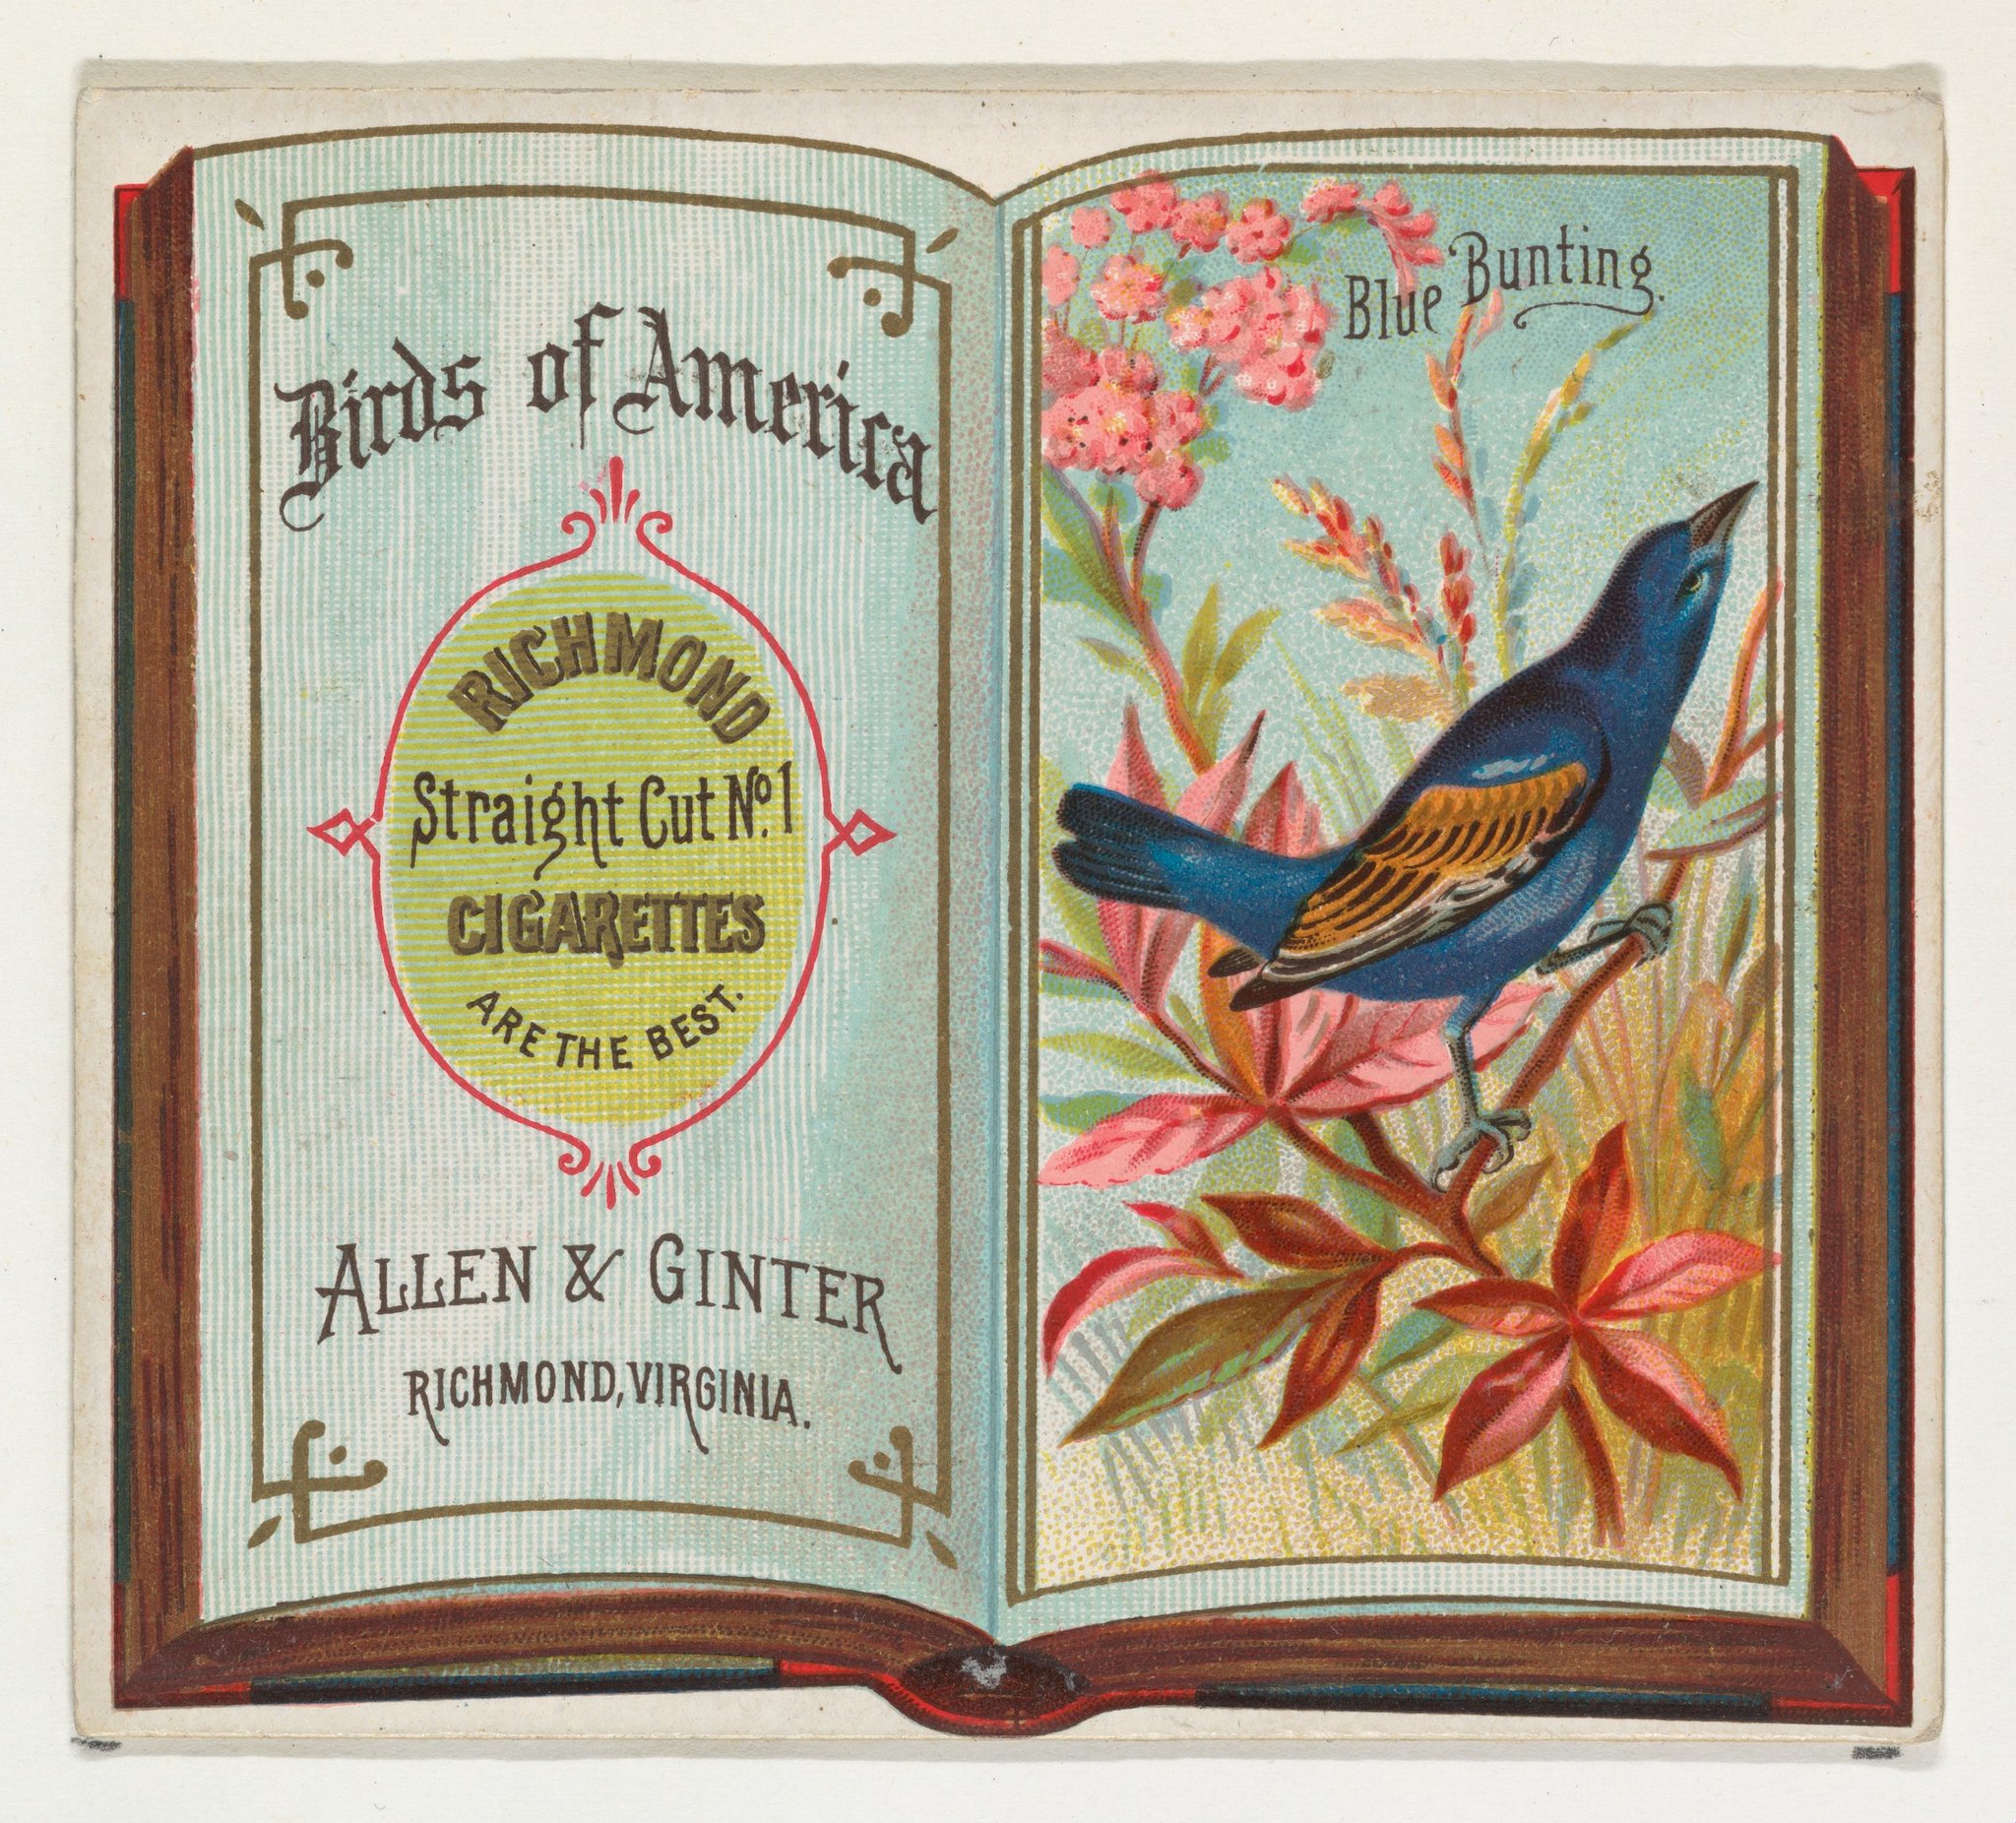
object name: print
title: Blue Bunting, from the Birds of America series (N37) for Allen & Ginter Cigarettes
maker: allen & ginter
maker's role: publisher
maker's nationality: american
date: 1888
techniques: color lithograph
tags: birds,flowers